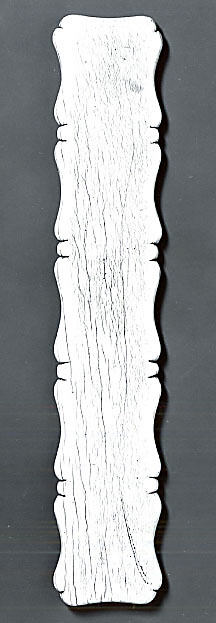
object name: wrist rest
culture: chinese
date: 1601-1700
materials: ivory